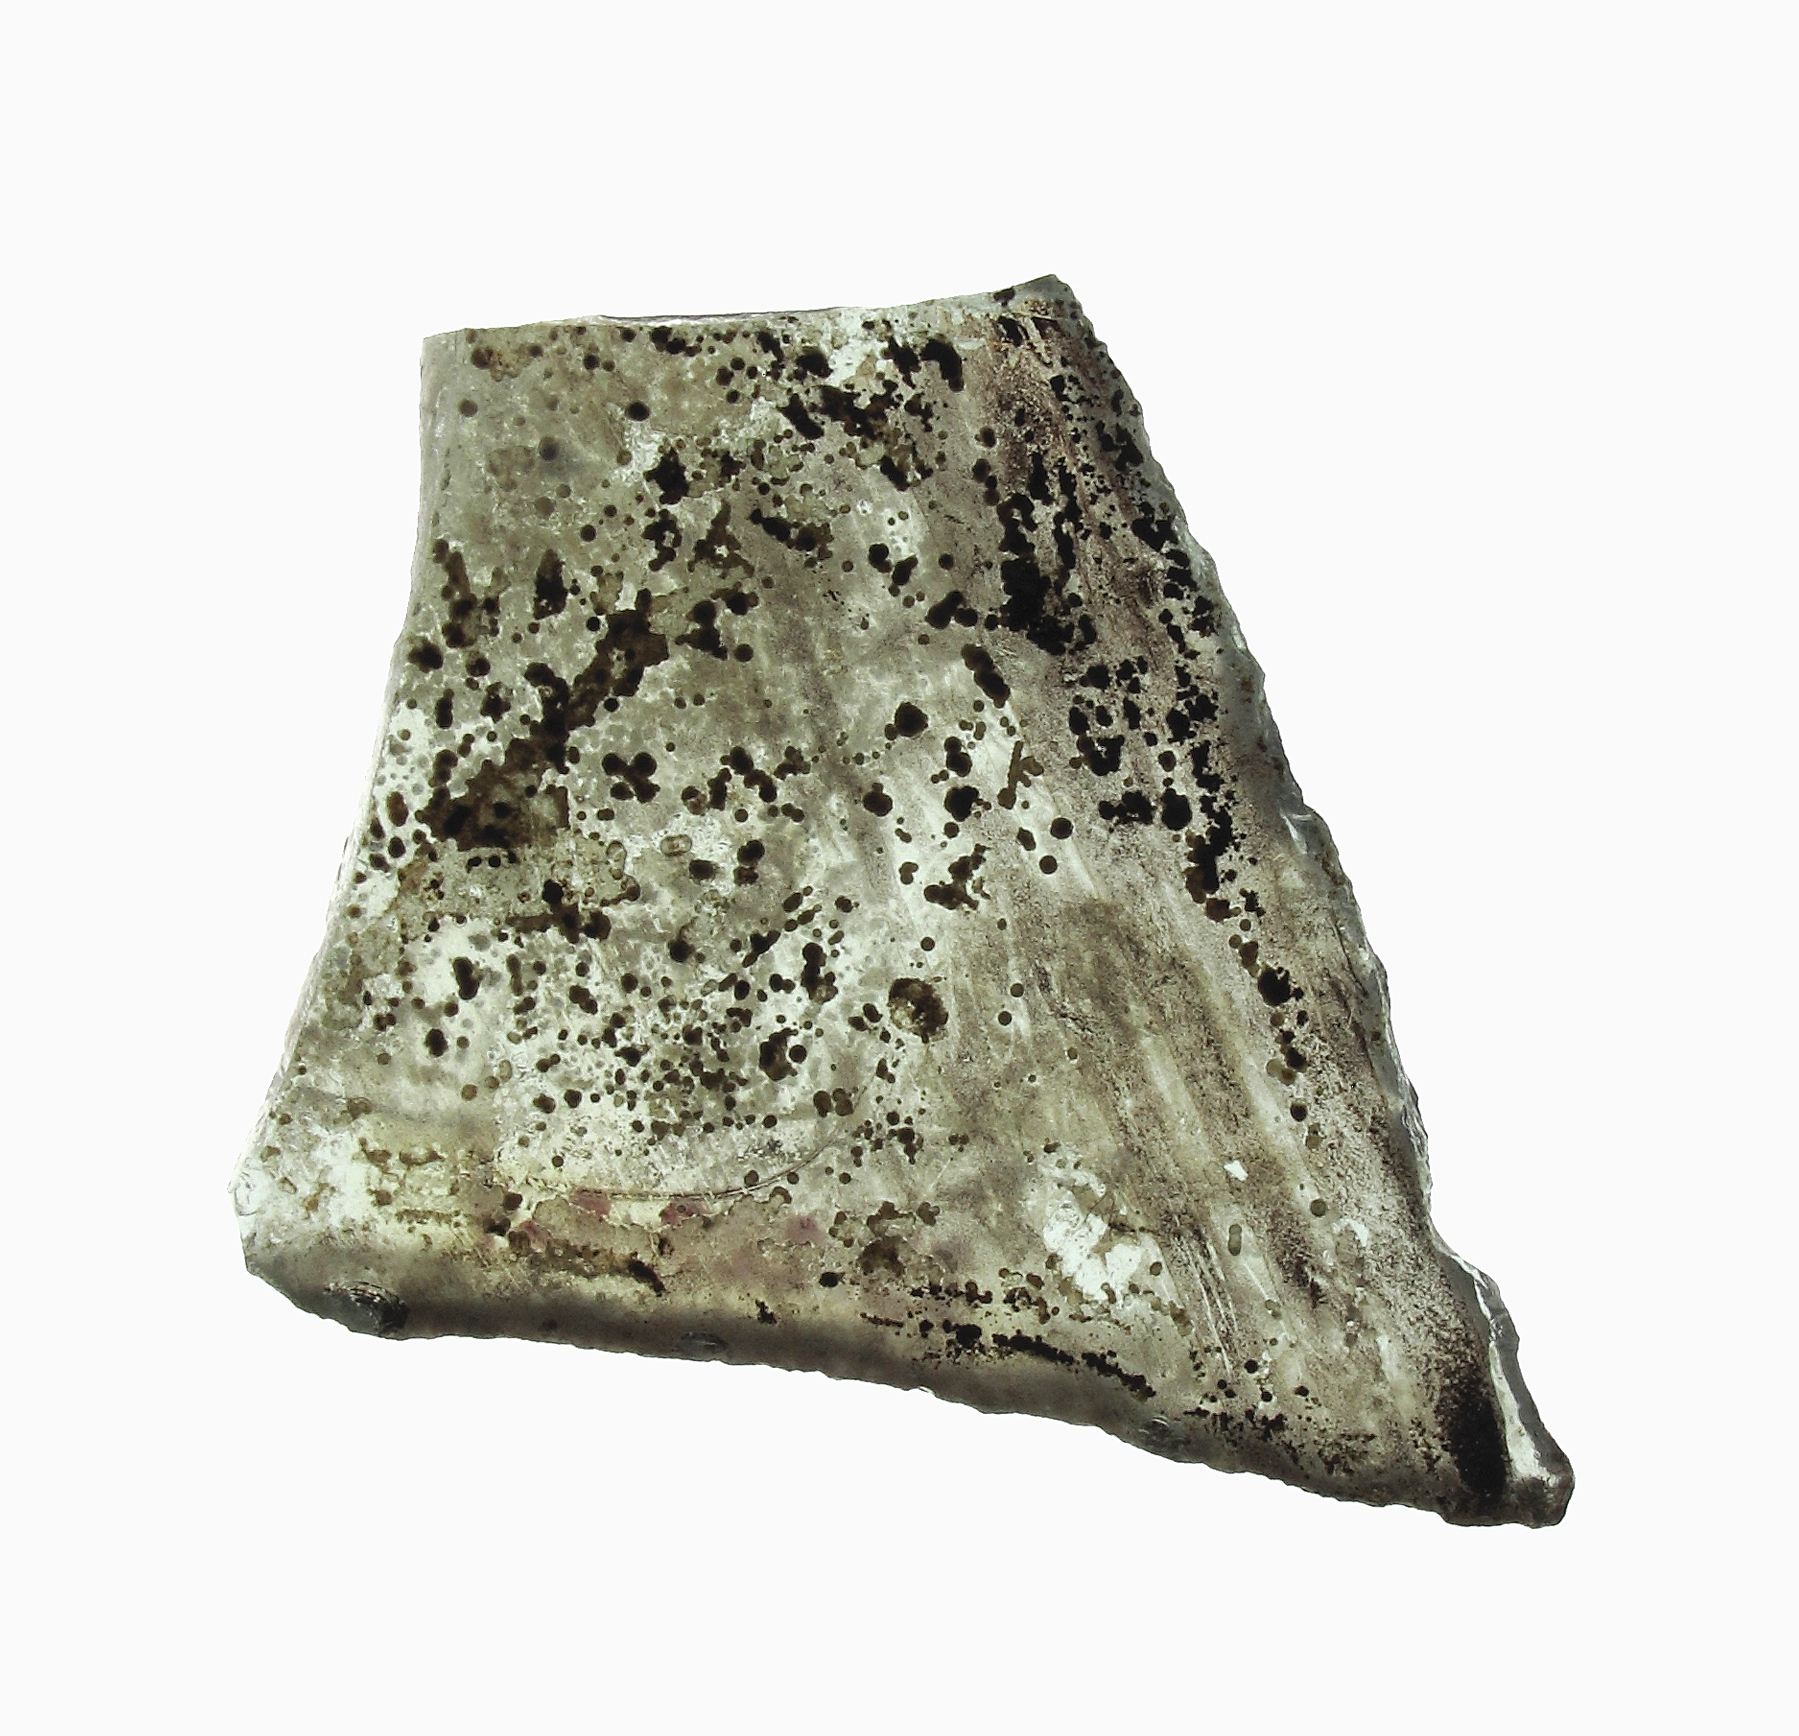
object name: fragment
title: Glass Fragment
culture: french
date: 1301-1400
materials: glass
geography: france